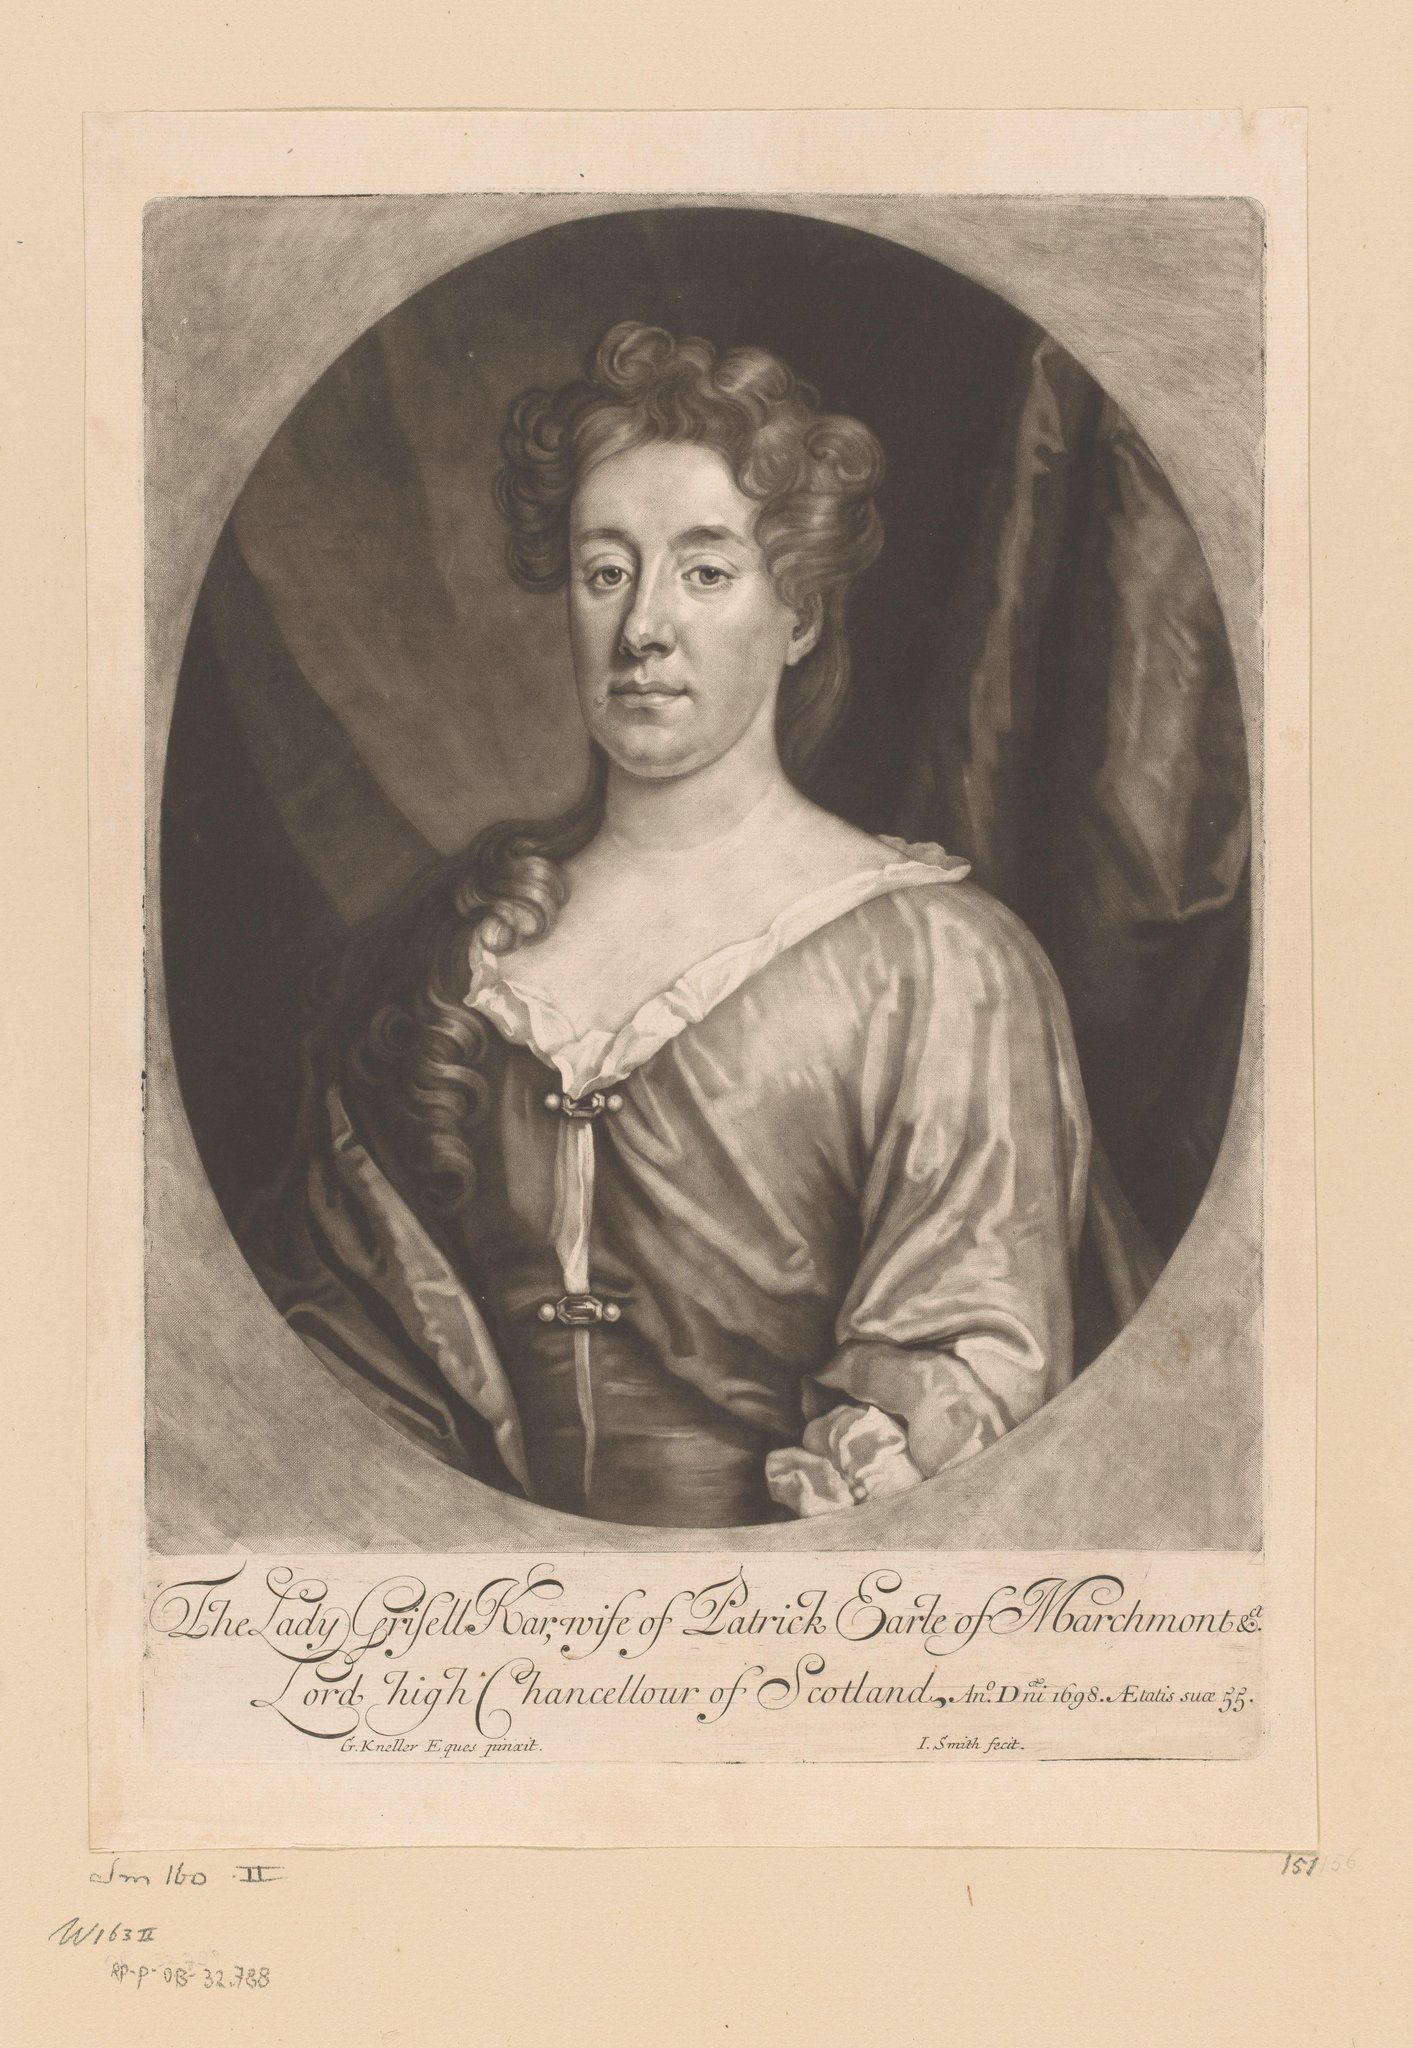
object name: print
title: The Lady Grisell Kar, wife of Patrick Earle of Marchmont (...)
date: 1698-1742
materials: paper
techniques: mezzotint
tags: historical persons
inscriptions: collector's mark: Lugt 240